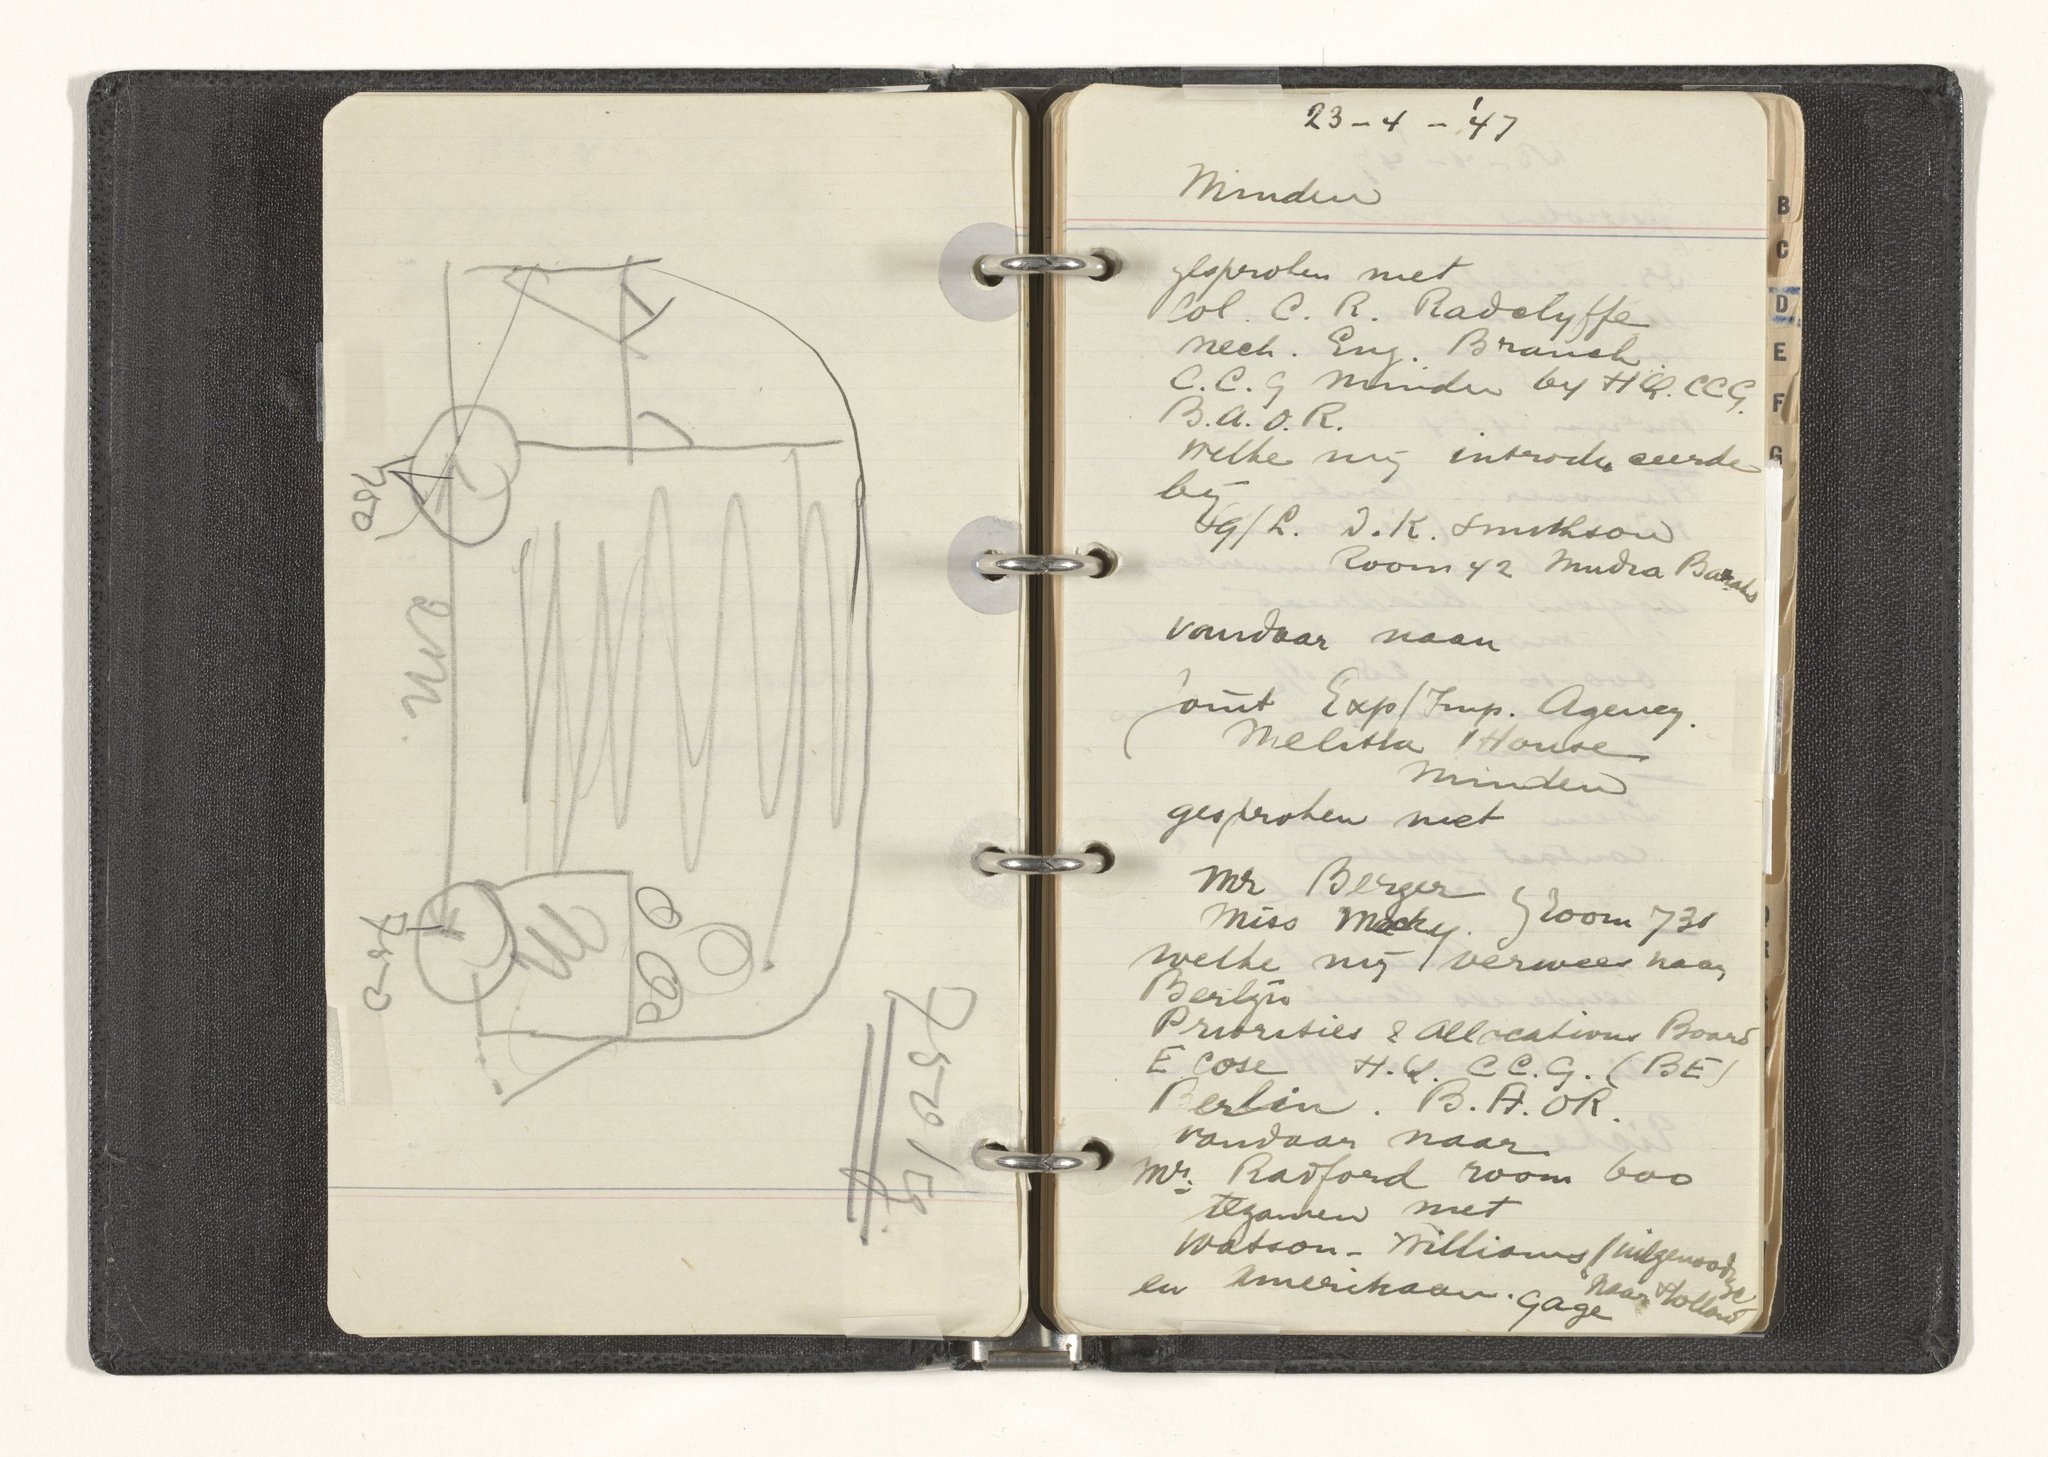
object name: notebook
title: Notitieboek met de eerste schets van 'Volkswagenbusje'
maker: ben pon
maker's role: importeur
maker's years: 1904-1968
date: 1947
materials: paper, pencil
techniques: sketch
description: Notitieboek met ringband, merk Soenecken. Met op een van de bladzijden een potloodschets van een transportbusje in zijaanzicht. Voor bijbehorend documentatie en beeldmateriaal zie NG-C-2012-2-2.